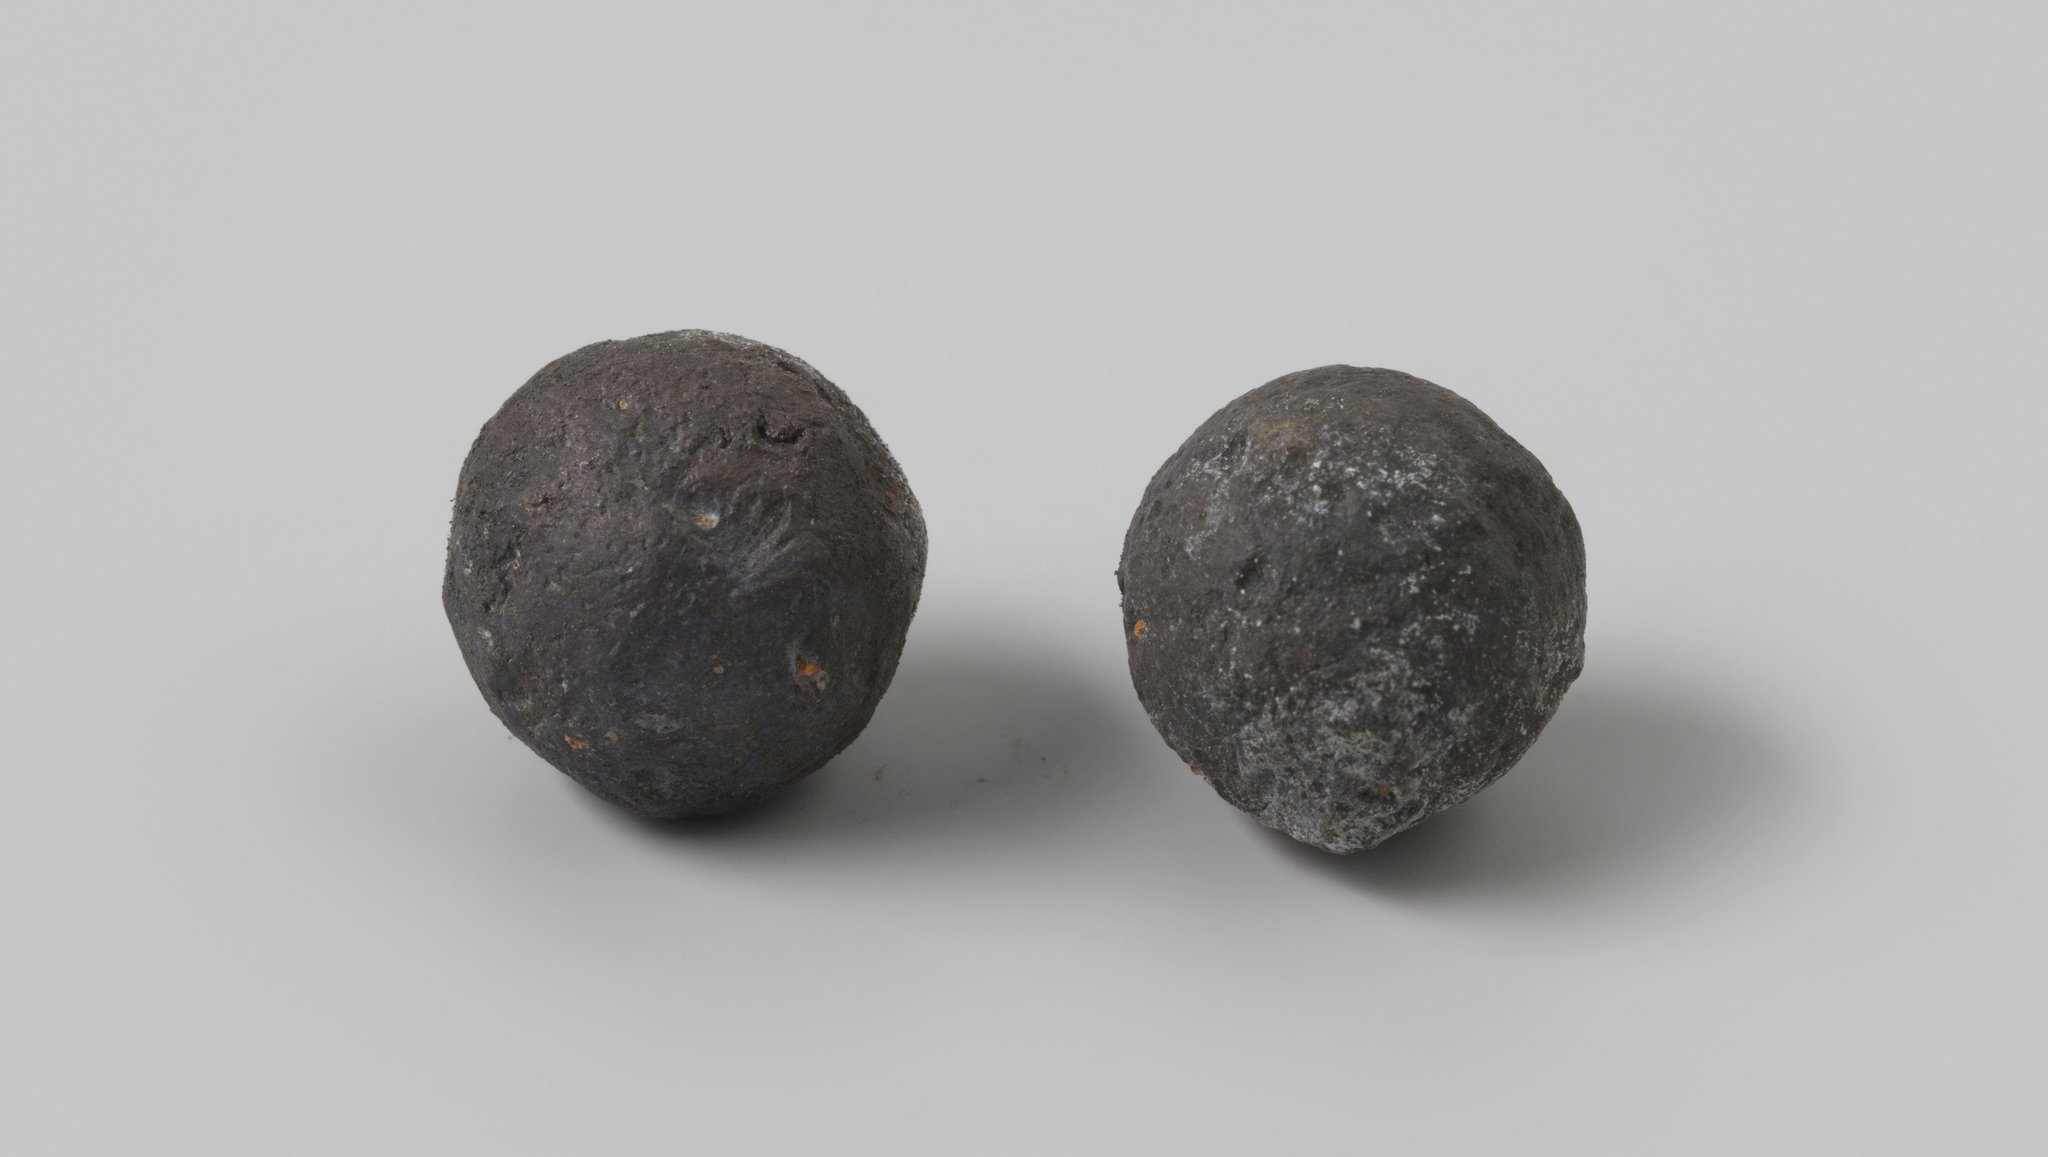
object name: musketkogel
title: Musketkogels uit het wrak van de Oost-Indiëvaarder Hollandia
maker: Anonymous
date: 1700-1743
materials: lead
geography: netherlands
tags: verenigde oostindische compagnie, hollandia (schip), annet